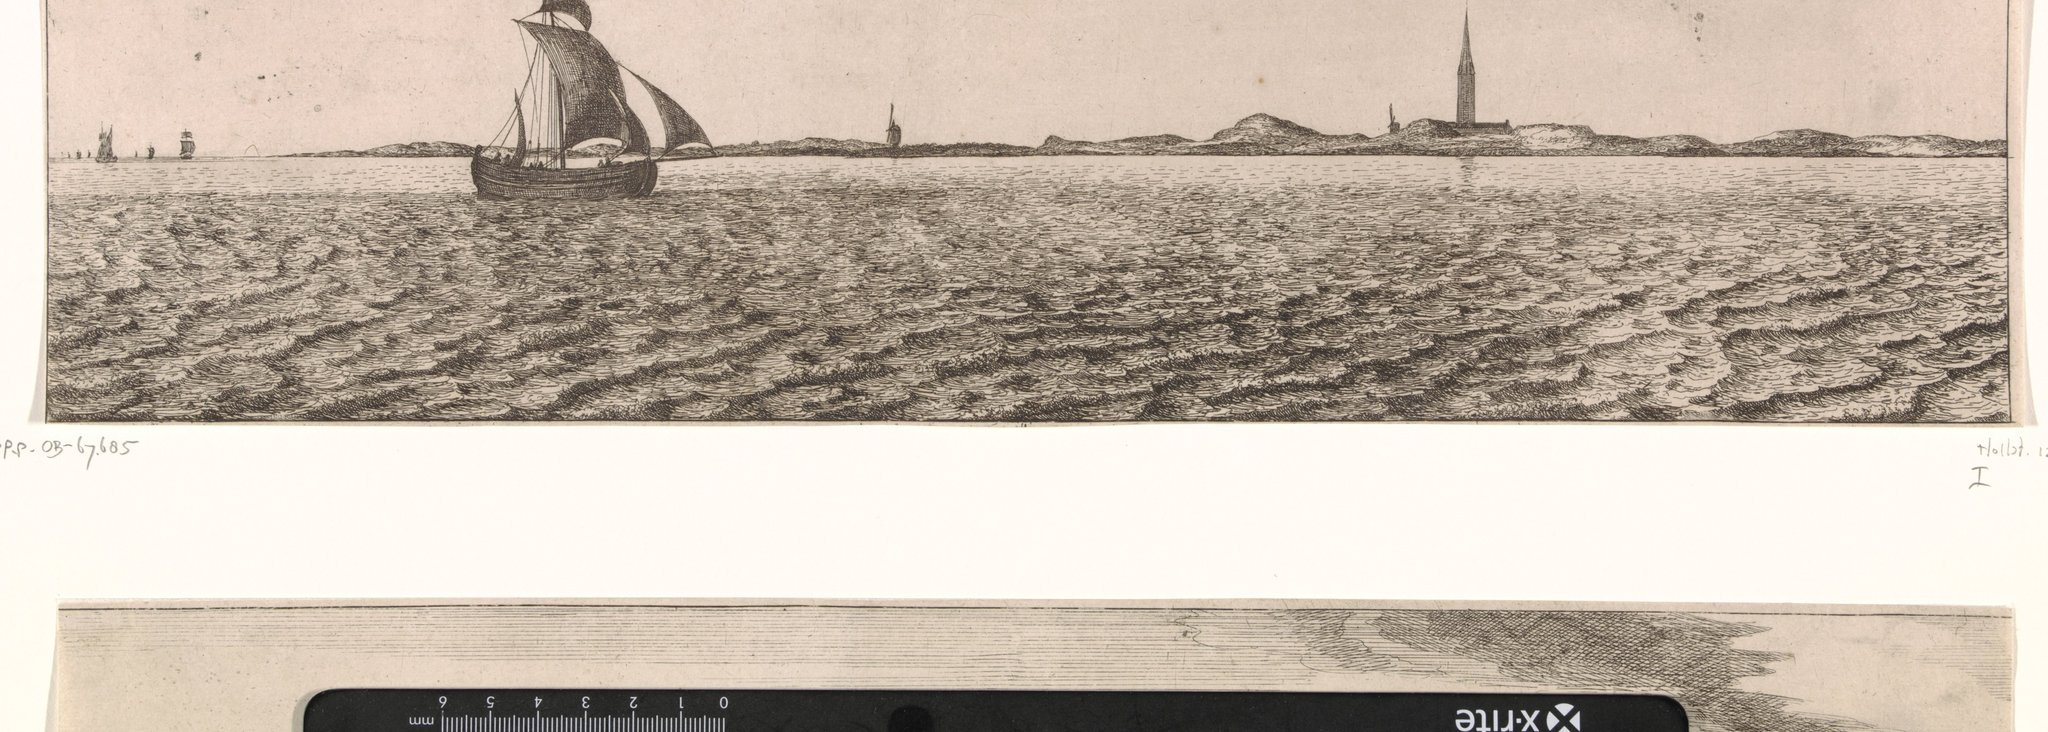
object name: print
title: Gezicht op 's-Gravenzande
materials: paper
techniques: engraving, etching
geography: rotterdam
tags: city-view in general; 'veduta', river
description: Gezicht op de noordkant van de Maas met op de achtergrond de stad 's-Gravenzande.